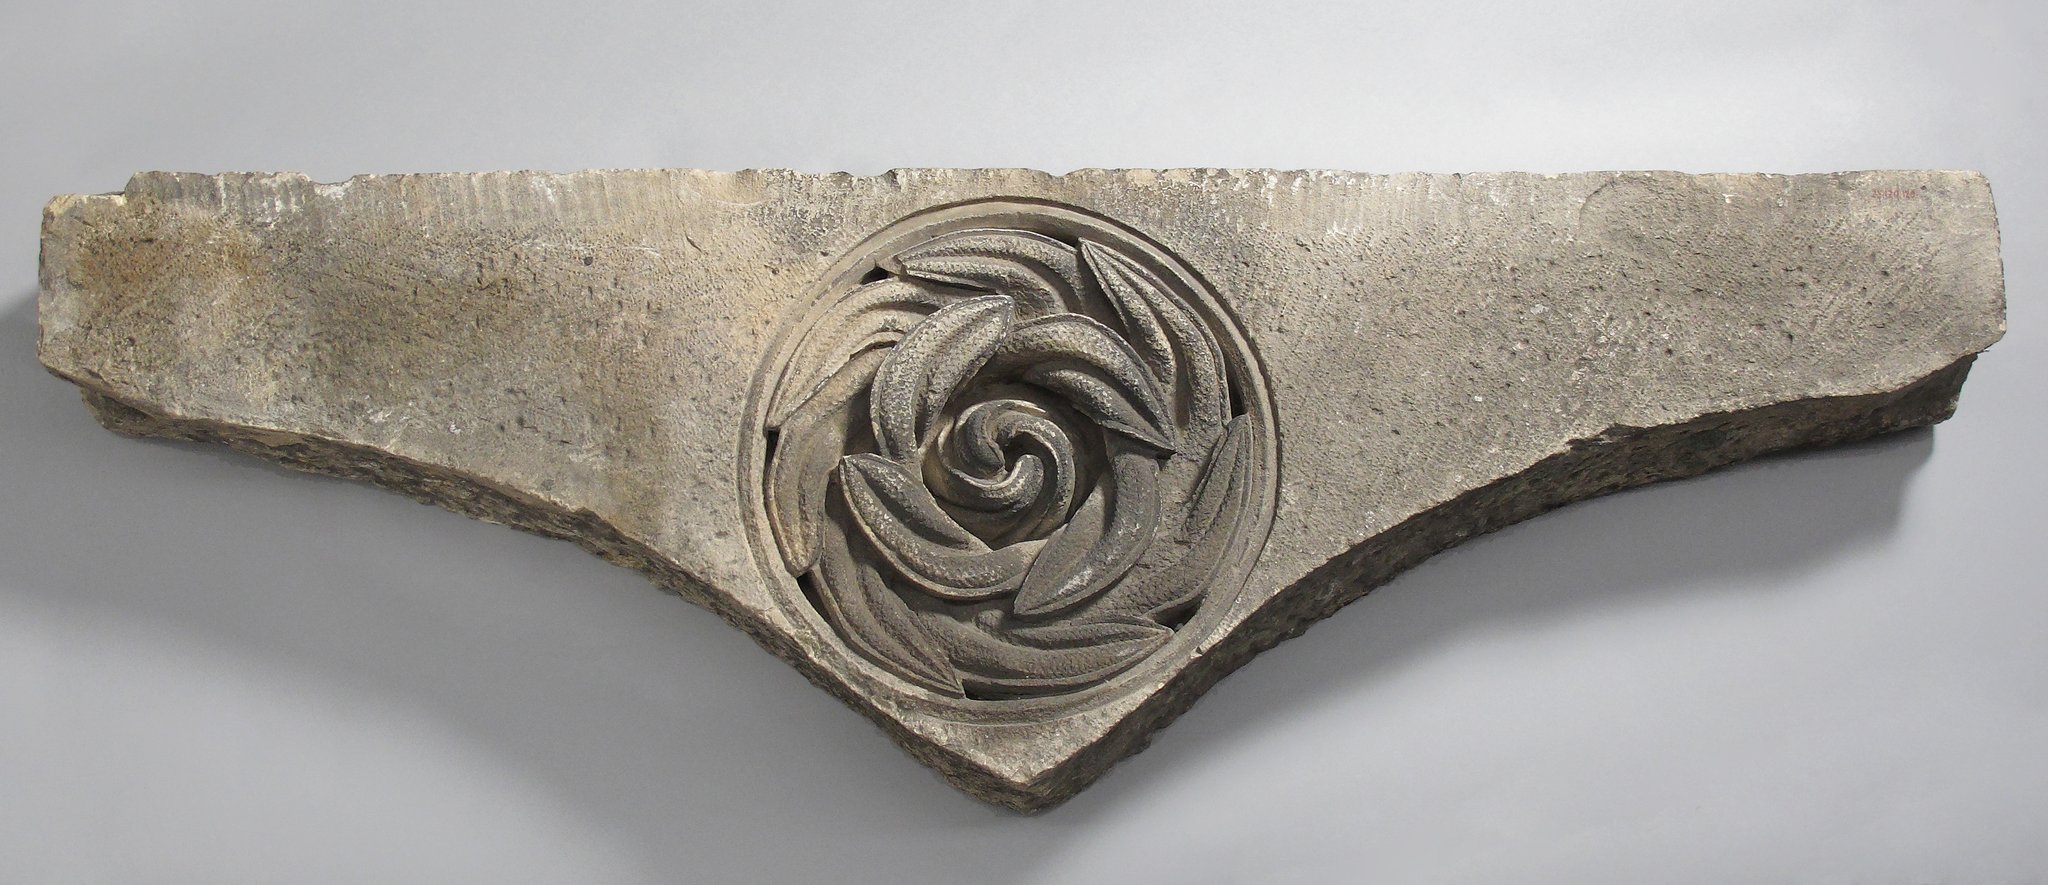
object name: relief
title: Fragment with Relief Decoration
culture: french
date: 1101-1300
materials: stone